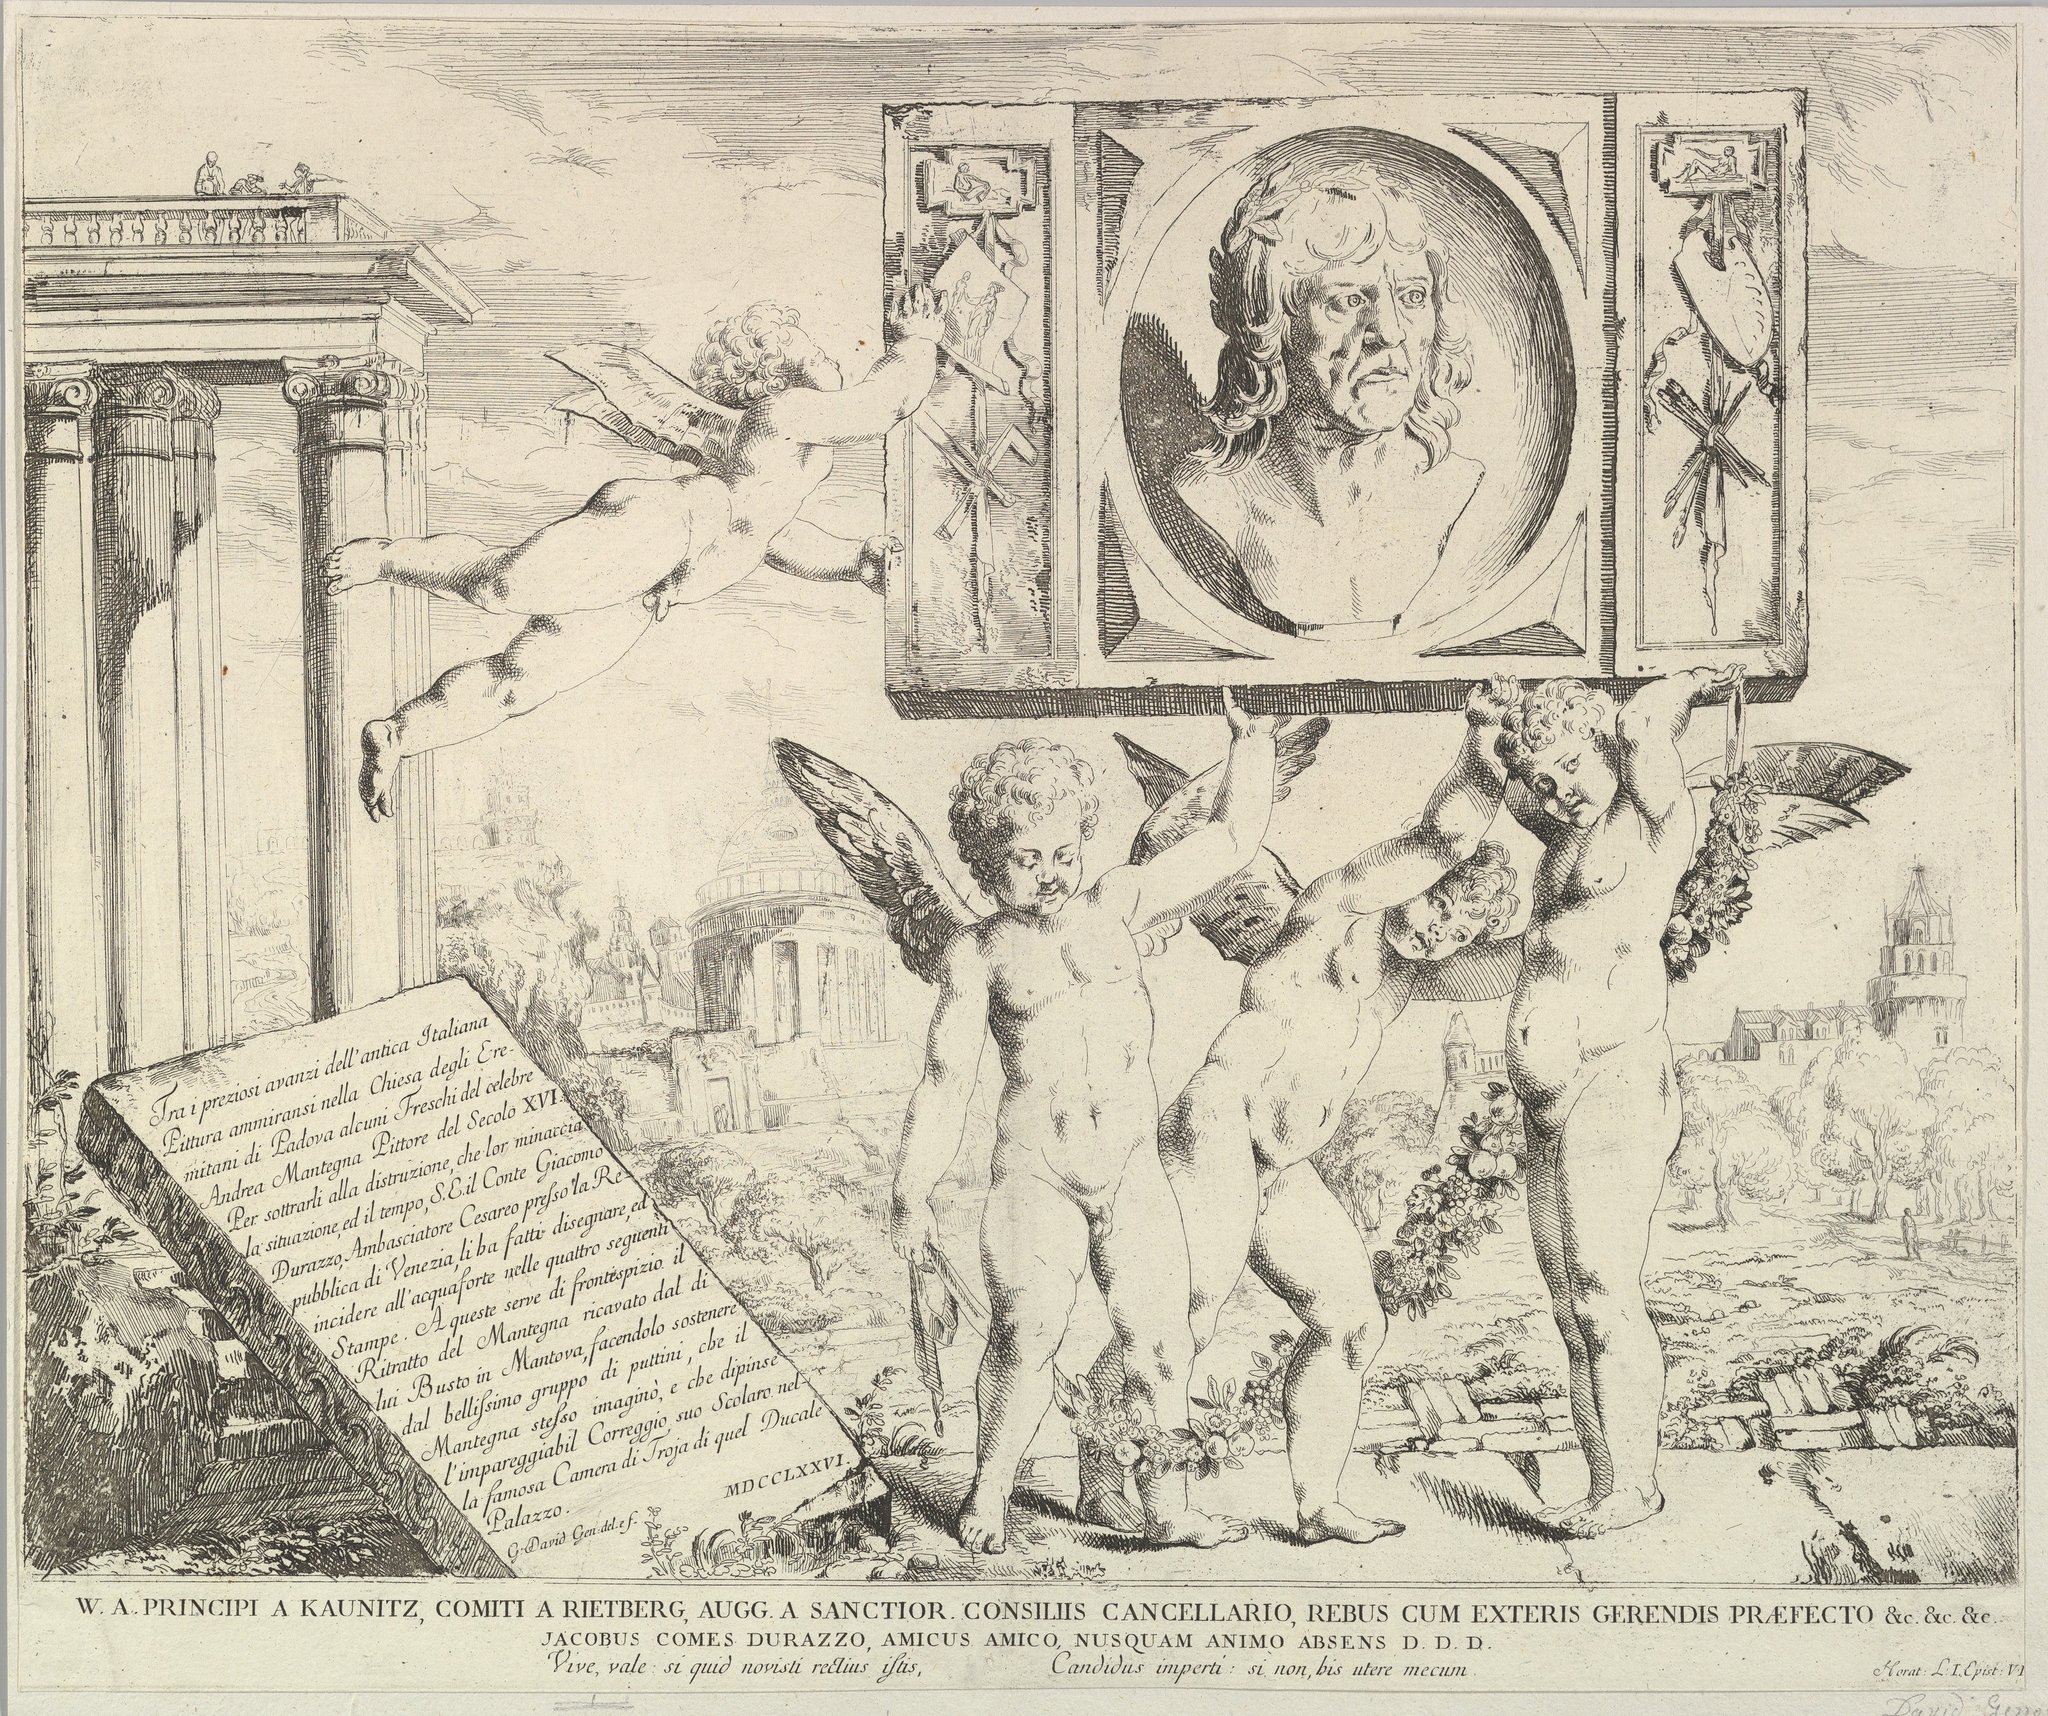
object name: print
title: Title page: Homage to Mantegna, from "The Story of Saints James and Christopher in the Eremitani Chapel"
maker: giovanni david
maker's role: artist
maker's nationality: italian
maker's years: 1749-1790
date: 1776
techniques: etching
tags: men,putti